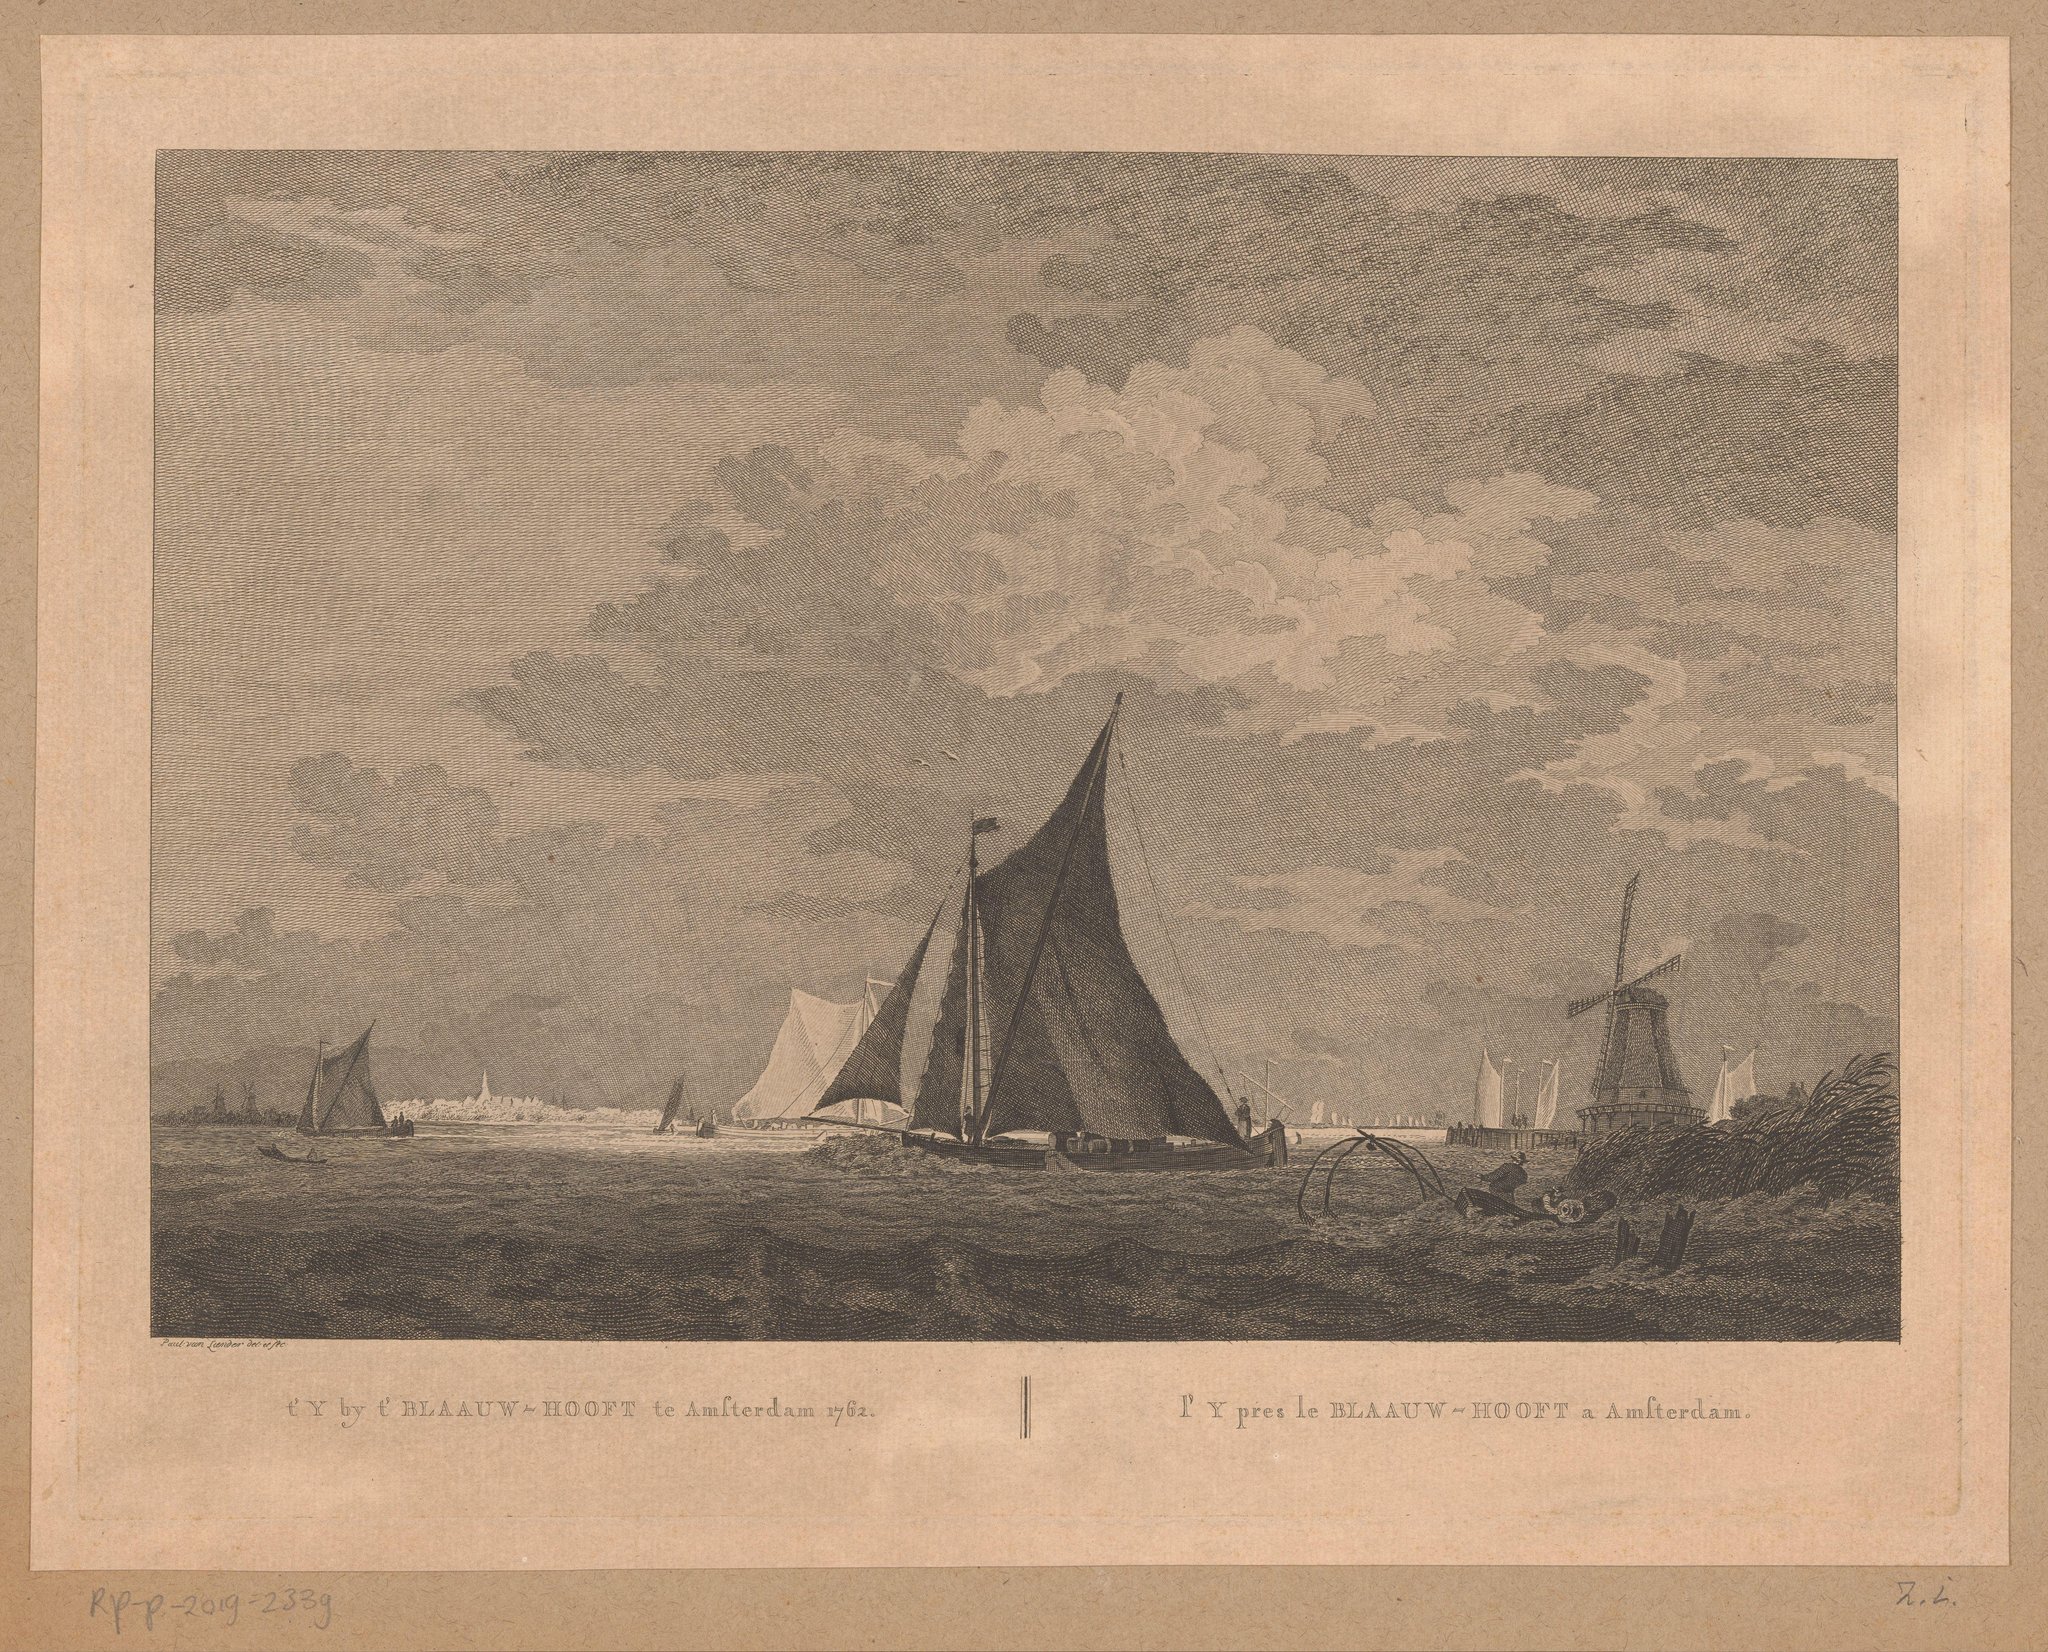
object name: print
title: Schepen op het IJ bij het Blauwhoofd te Amsterdam, 1762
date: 1762-1783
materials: paper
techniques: etching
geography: netherlands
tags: sailing-ship, sailing-boat, windmill in landscape, prospect of city, town panorama, silhouette of city, amsterdam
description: Vanaf 1760 gaf Pierre Fouquet stadsgezichten van Amsterdam naar tekeningen van verschillende kunstenaars uit. Deze prenten werden aanvankelijk los verkocht. Later werden ze samengebonden verkocht in verschillende volgordes en aantallen in: (1). Afbeeldingen van de wyd-vermaarde koopstad Amsterdam benevens des zelvs voornaamste gebouwen en gezigten alle naar het leeven getekend / Receuil des edifices les plus considerables et des plus belles vues, de la fameuse ville d'Amsterdam, dessinées d'après nature. Amsterdam: Pierre Fouquet, 1778-1783. Deze 'uitgave' bestond waarschijnlijk alleen uit een titelblad en inhoudsopgave van de tot dusver 100 uitgegeven prenten, die de koper zelf aan zijn of haar reeds verzamelde prenten kon toevoegen. De hoeveelheid en volgorde van prenten verzameld onder deze titel verschilt dus sterk. (2). Nieuwe atlas, van de voornaamste gebouwen en gezigten der stad Amsterdam, met derzelver beknopte beschryvingen. 2 dln. Amsterdam: Daniël Jean Changuion en Petrus den Hengst [in opdracht van Pierre Fouquet], 1783. Ook werden er door verschillende uitgevers tussen 1788 (Amsterdam: Petrus Conradi) en 1805 (Amsterdam: Evert Maaskamp) heruitgaven gepubliceerd.